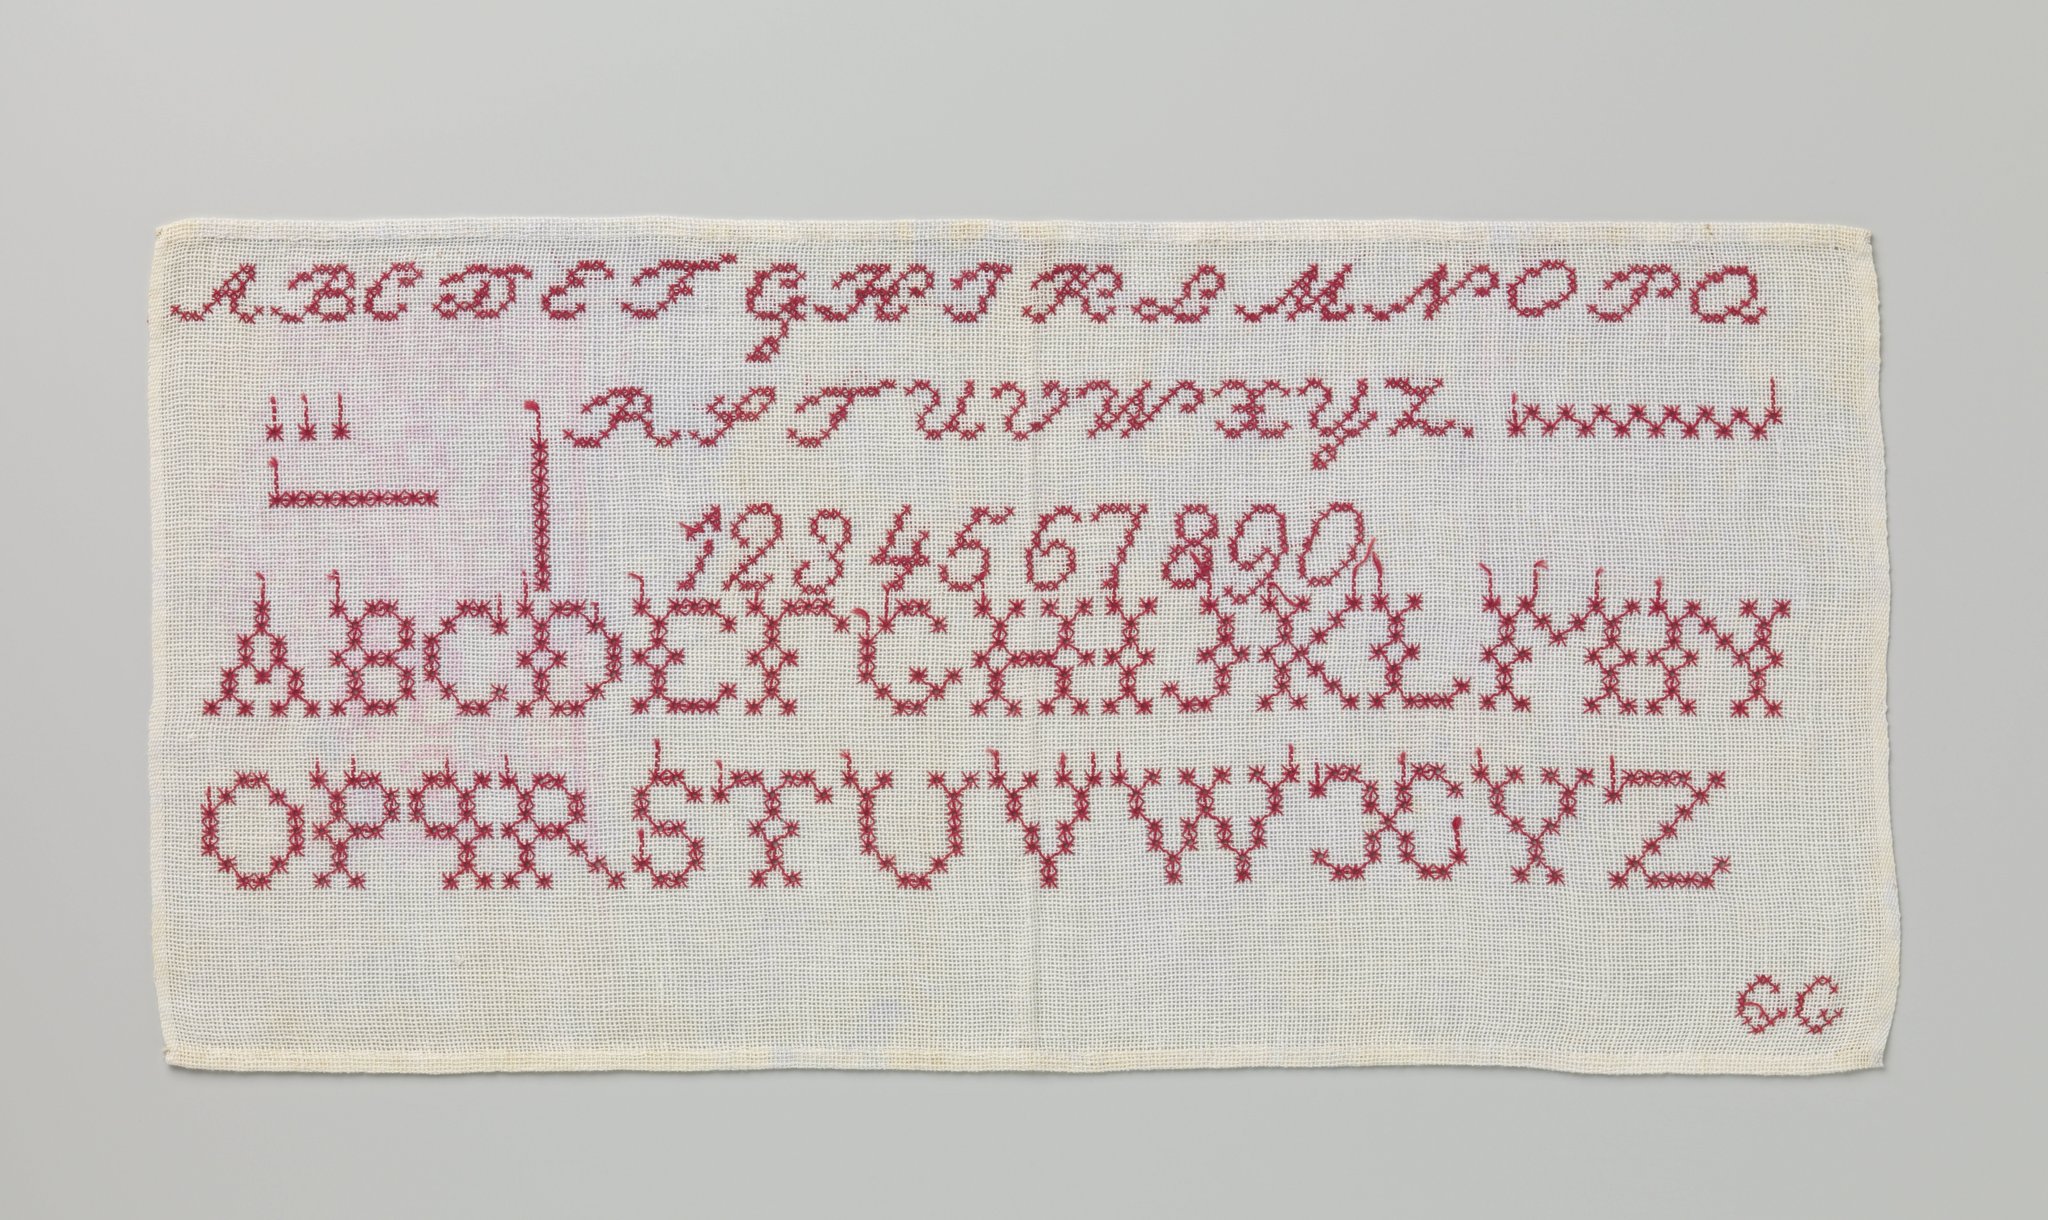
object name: handwerk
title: Merklap van linnen met een stramien van rode letters en cijfers, gemerkt: GG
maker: g. glas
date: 1888-1894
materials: linen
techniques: embroidered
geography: deventer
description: Vervaardigd op de Normaalschool te Deventer voor de akte 'Nuttige handwerken'.